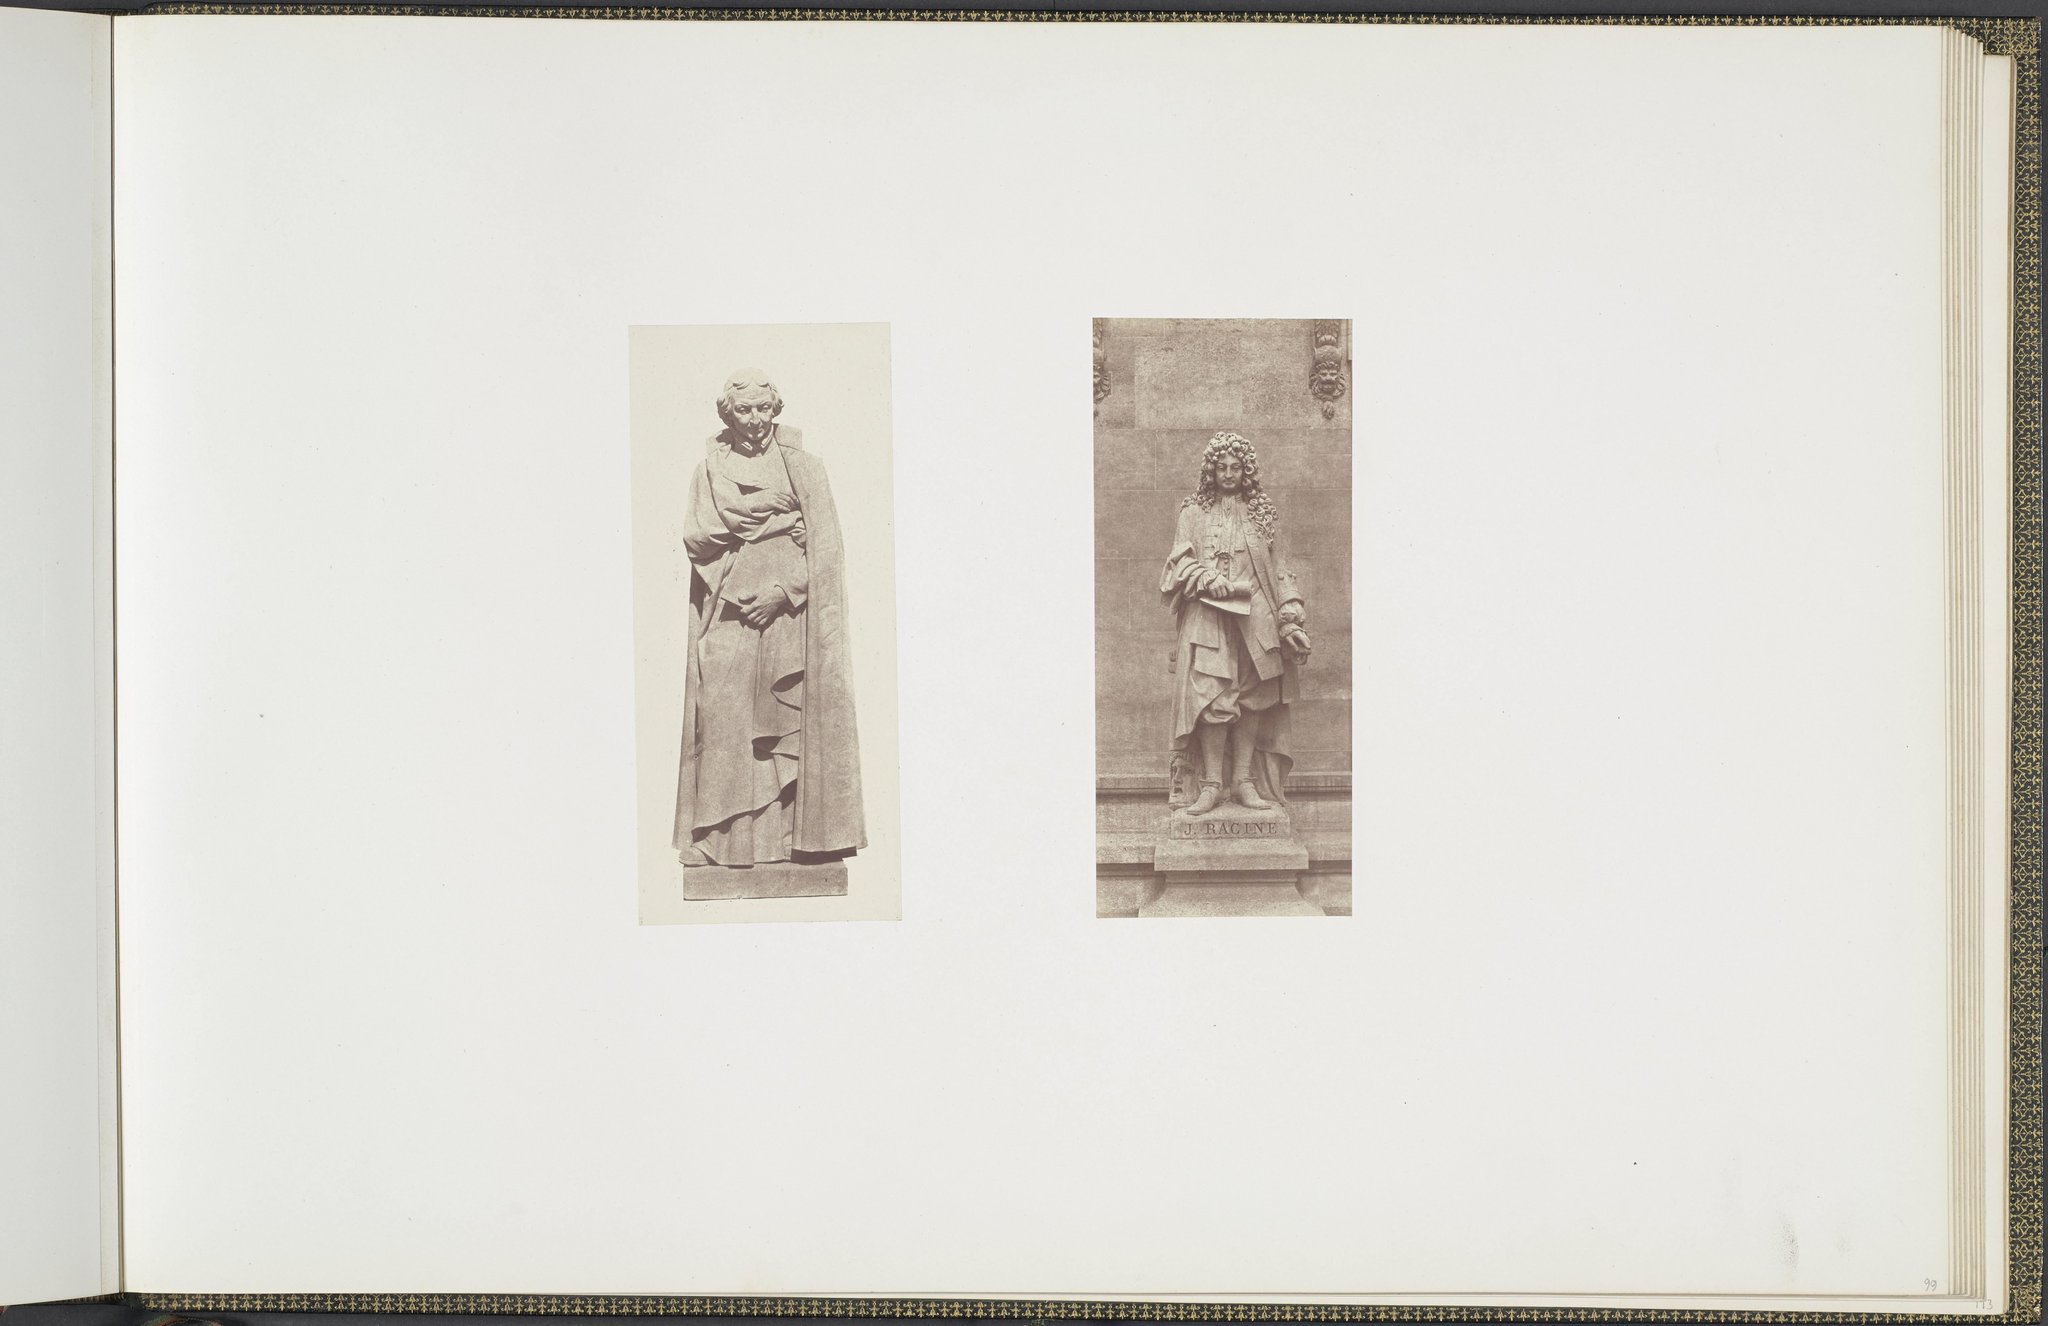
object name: album leaf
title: Gipsmodellen voor beeldhouwwerken op het Palais du Louvre: links "Bourdaloue"door Louis Desprez en rechts "Racine" door Michel-Pascal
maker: édouard denis baldus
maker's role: fotograaf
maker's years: 1813-1889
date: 1855-1857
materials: paper, photographic support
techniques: salted paper print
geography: paris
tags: piece of sculpture, reproduction of a piece of sculpture, permanent exhibition, museum, paris, tuileries palace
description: Onderdeel van Réunion des Tuileries au Louvre 1852-1857, album 1.